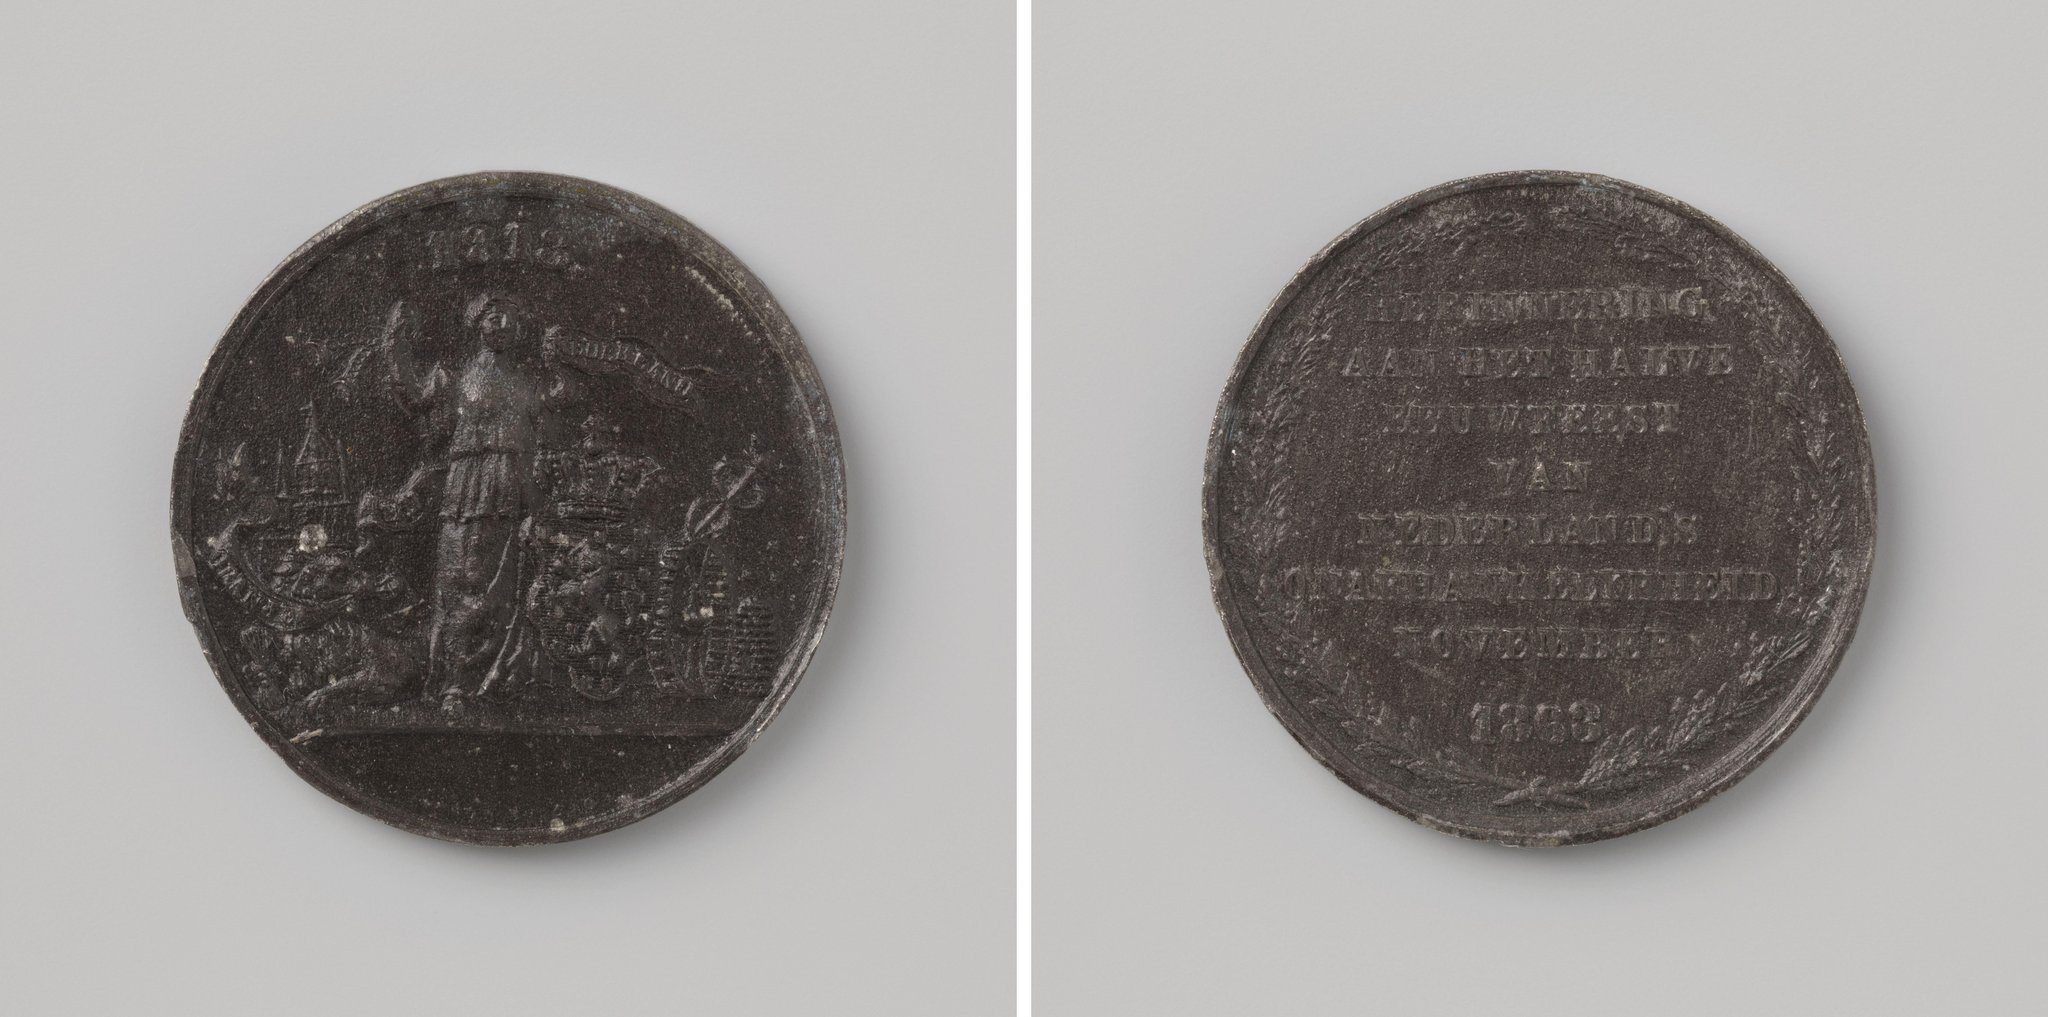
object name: history medal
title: Vijftigjarige viering van de onafhankelijkheid van Nederland te Rotterdam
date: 1863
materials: tin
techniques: striking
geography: the hague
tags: rotterdam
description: Tinnen penning. Voorzijde: Nederlandse maagd met in rechterhand verbroken ketens en in linkerhand gekroond wapenschild staat tussen liggende leeuw met pijlenbundel en wimpel met opschrift in bek, en mercuriusstaf, rad, bijenkorf en bijen; op achtergrond schip op zee. Keerzijde: opschrift binnen eikekrans